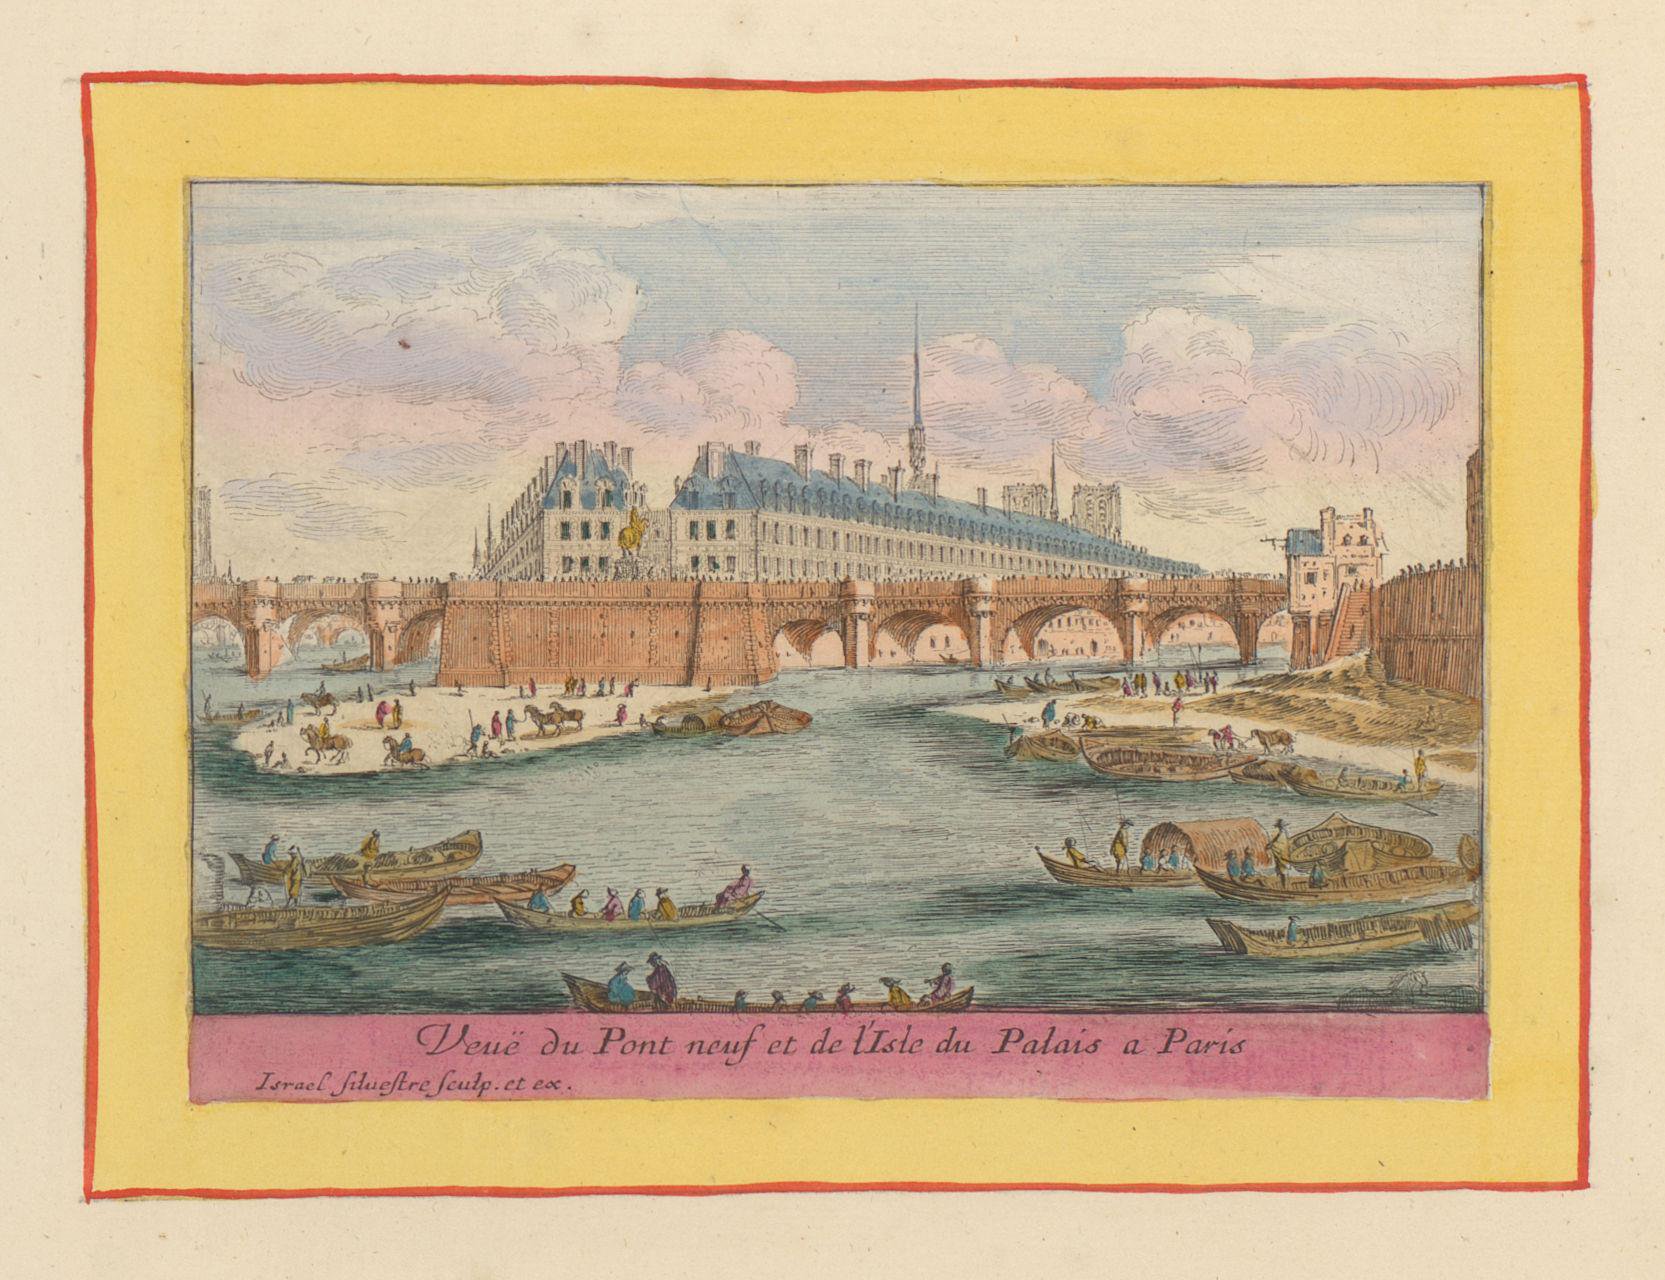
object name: album leaf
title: Veuë du Pont neuf et de l'Isle du Palais a Paris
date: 1631-1691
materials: paper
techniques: etching, hand coloring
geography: paris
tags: river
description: Gezicht op Pont Neuf en Îsle de la Cité te Parijs. Prent maakt deel uit van een album.